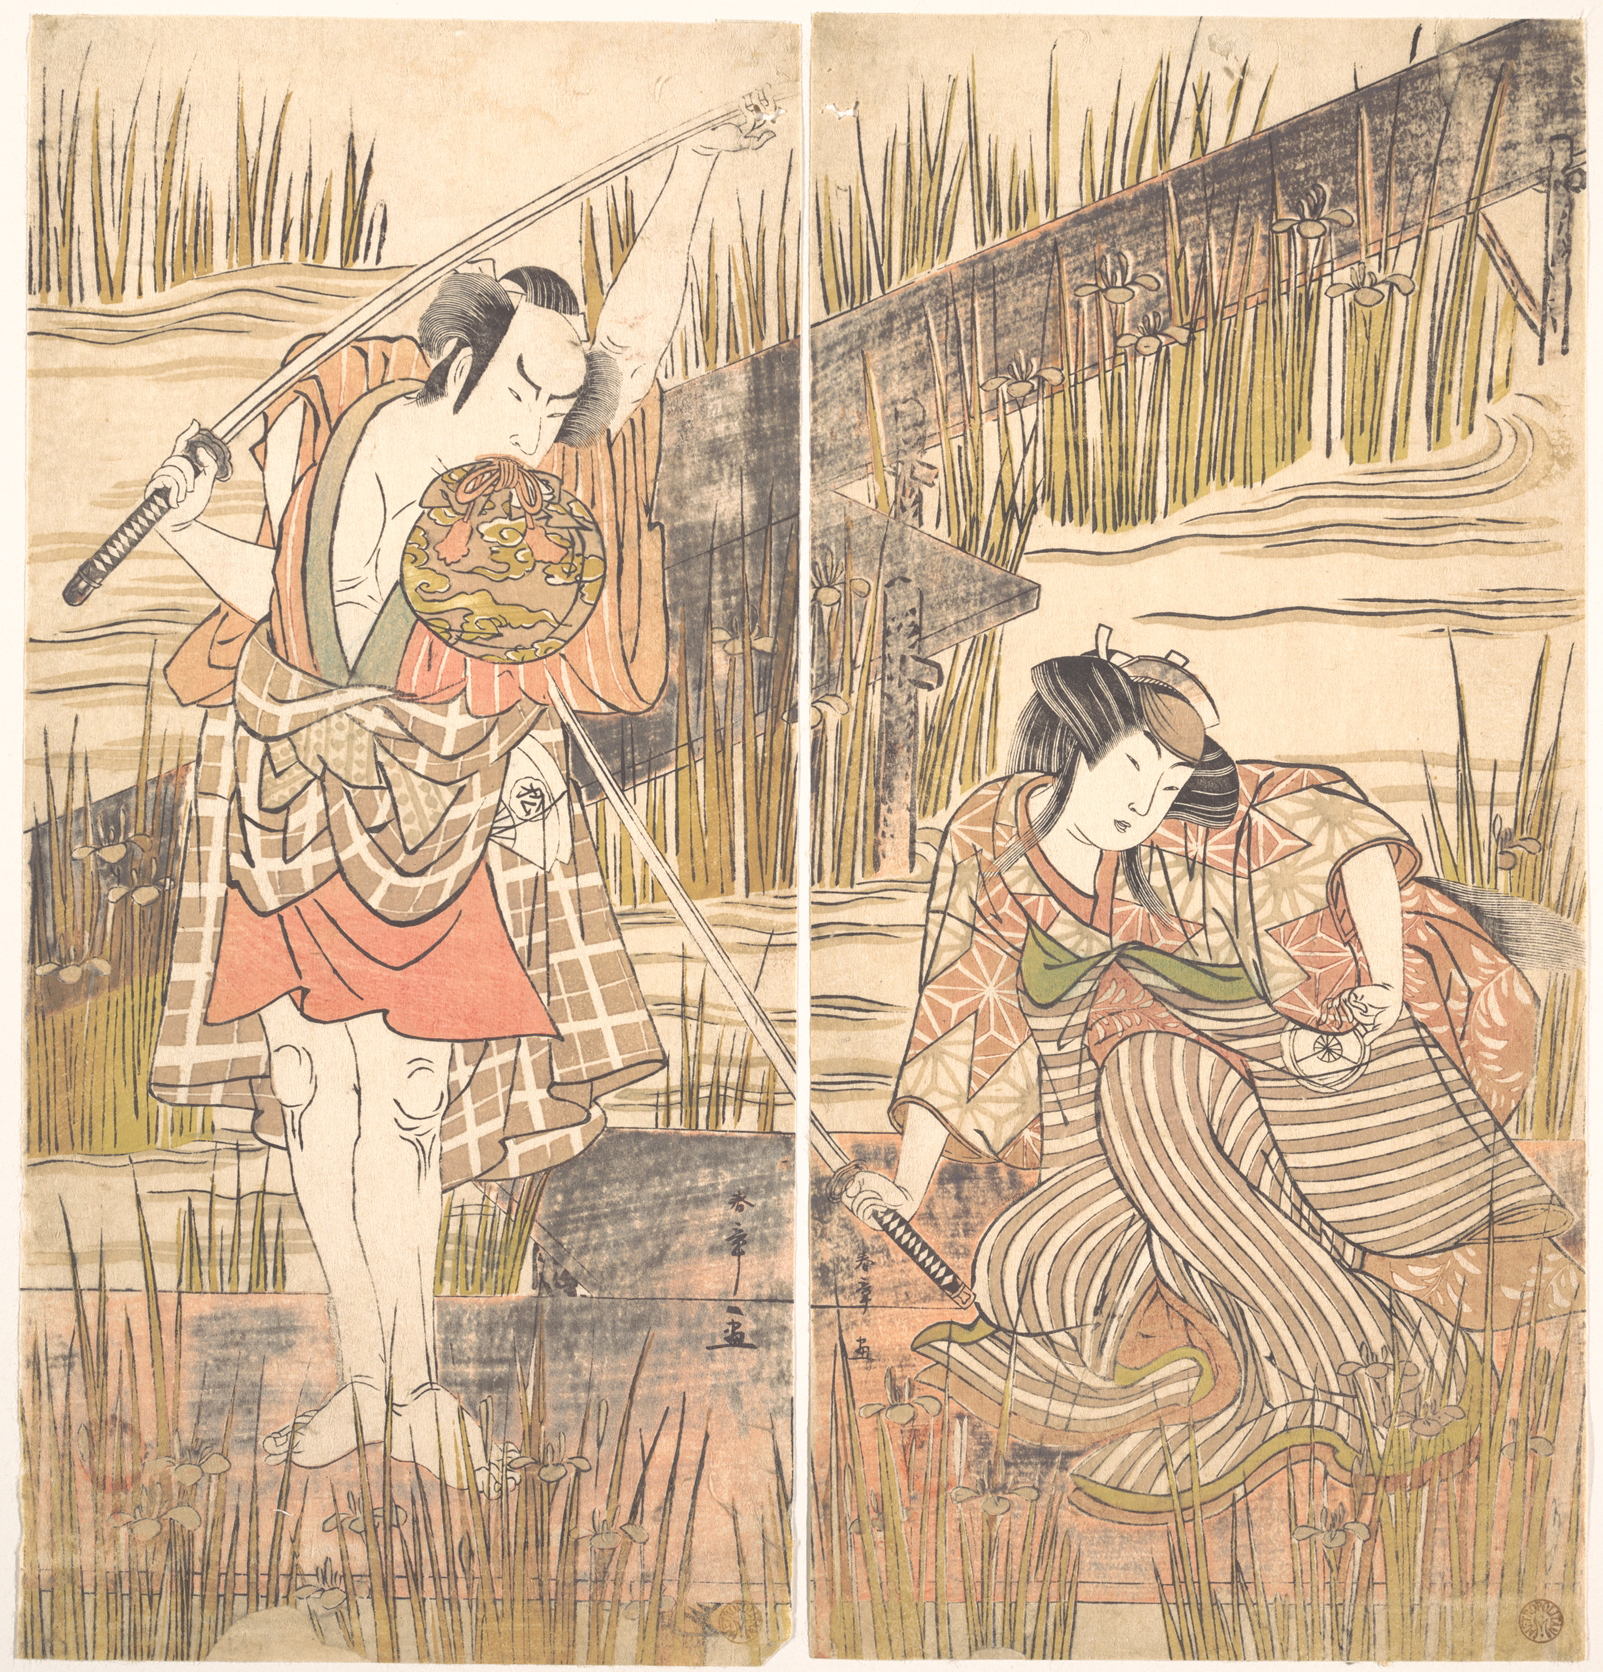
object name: woodblock print nishiki e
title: The Actor Onoye Matsusuke with Sword Held Above His Head with Both Hands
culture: japanese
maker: katsukawa shunshō 勝川春章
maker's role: artist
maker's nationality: japanese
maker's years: 1726-1792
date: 1778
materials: ink, paper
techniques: nishiki e, woodblock print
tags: swords,men,women,actors